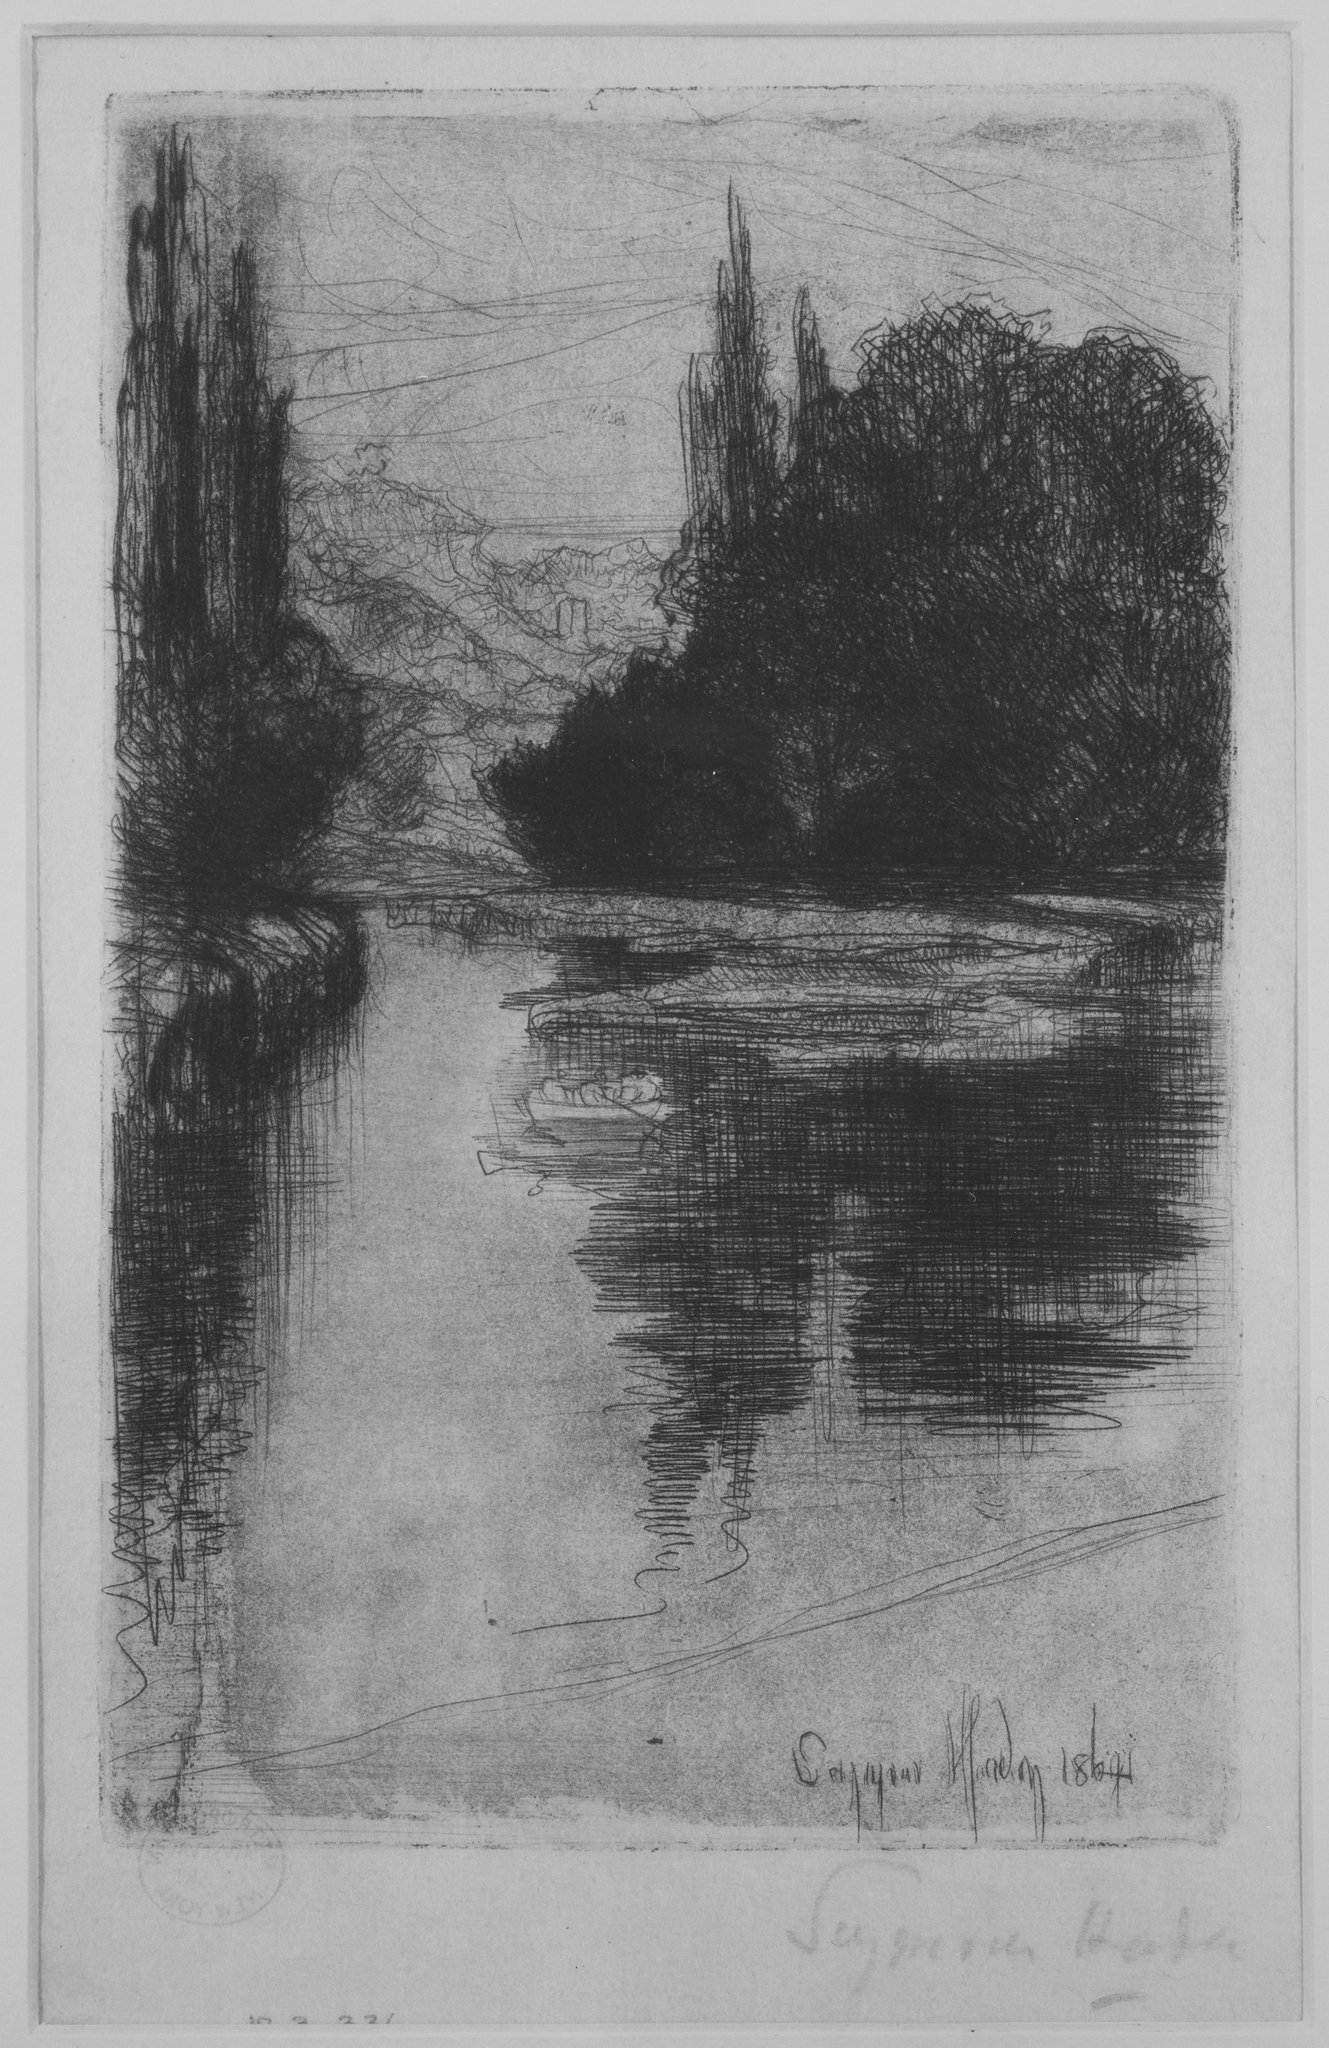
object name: print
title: The Charmers of the Age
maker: james sayers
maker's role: artist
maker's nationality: british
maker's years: 1748-1823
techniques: aquatint, etching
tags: landscapes